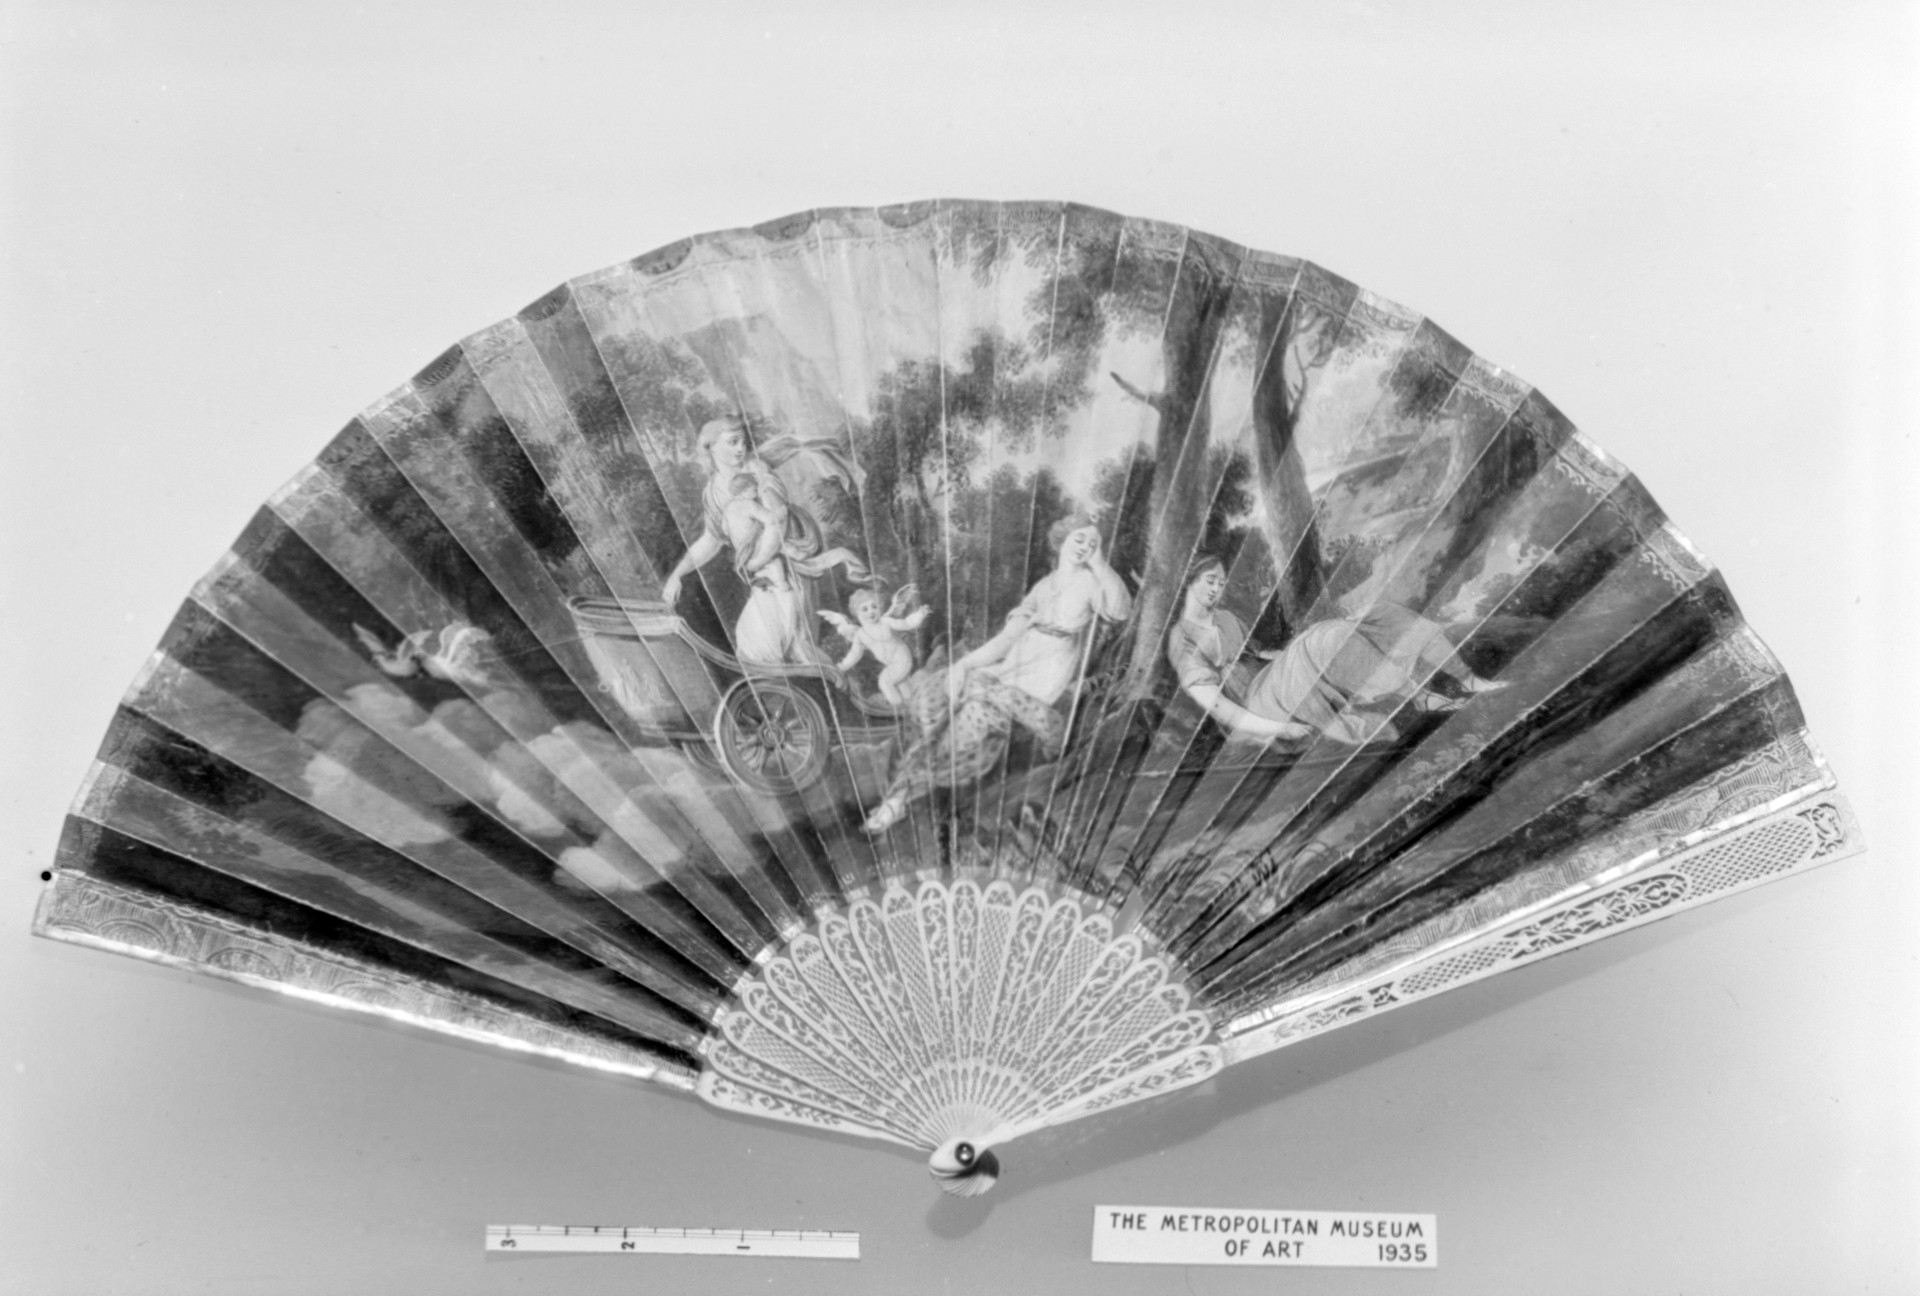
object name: fan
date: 1815-1825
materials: ivory, paper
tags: sleeping,women,chariots